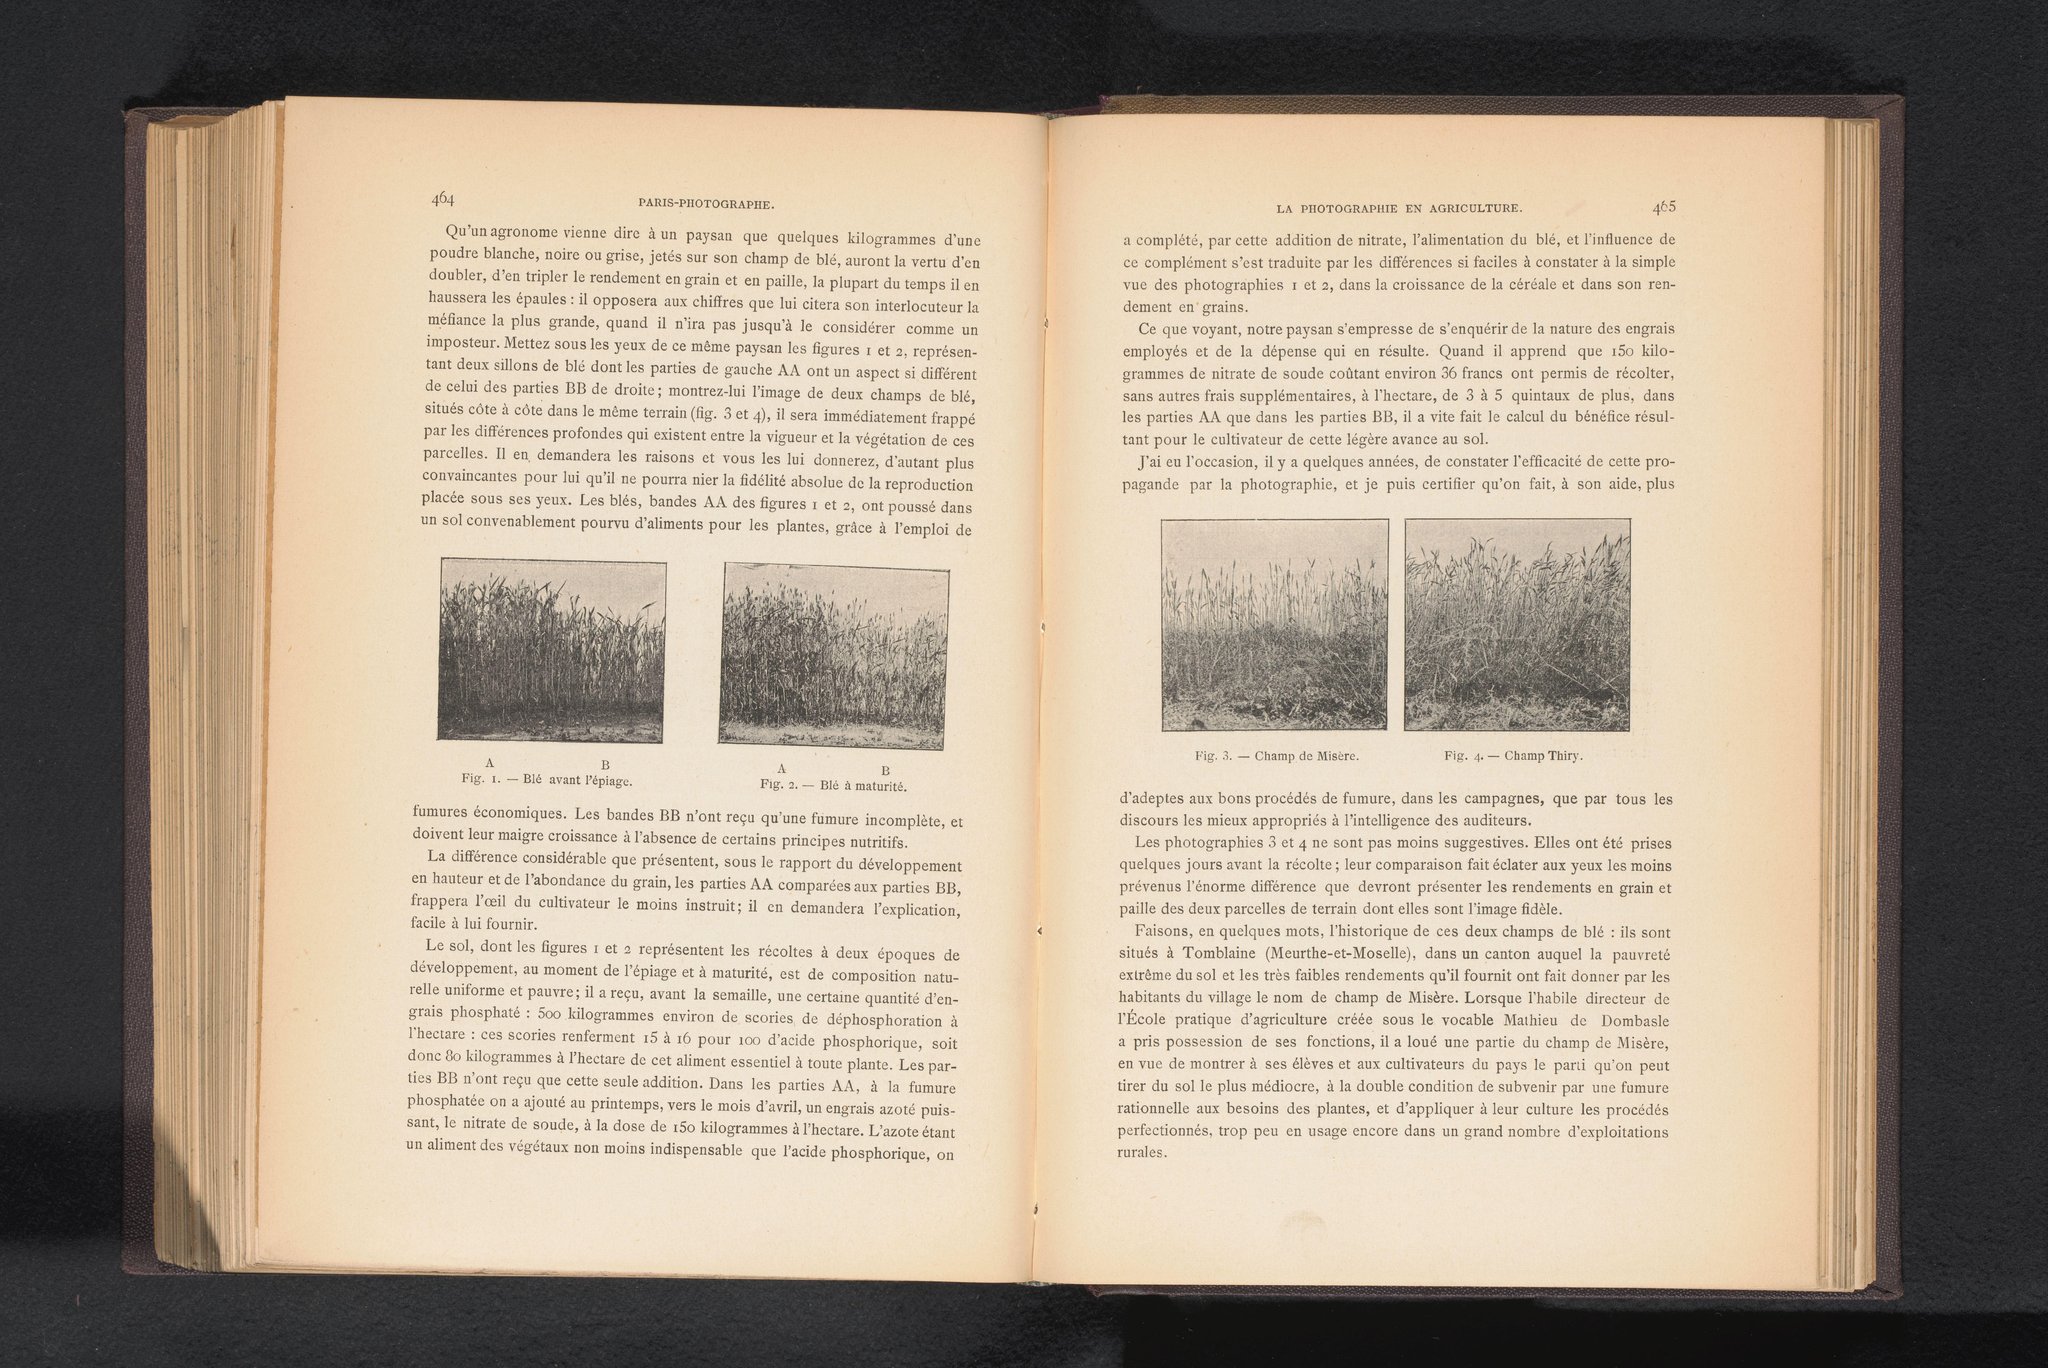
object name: photomechanical print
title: Blé avant l'epiage. Blé à maturité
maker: Anonymous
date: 1882-1892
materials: paper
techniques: autotype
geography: france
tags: plants and herbs: wheat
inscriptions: number: ‘Fig. 1. Fig. 2.’